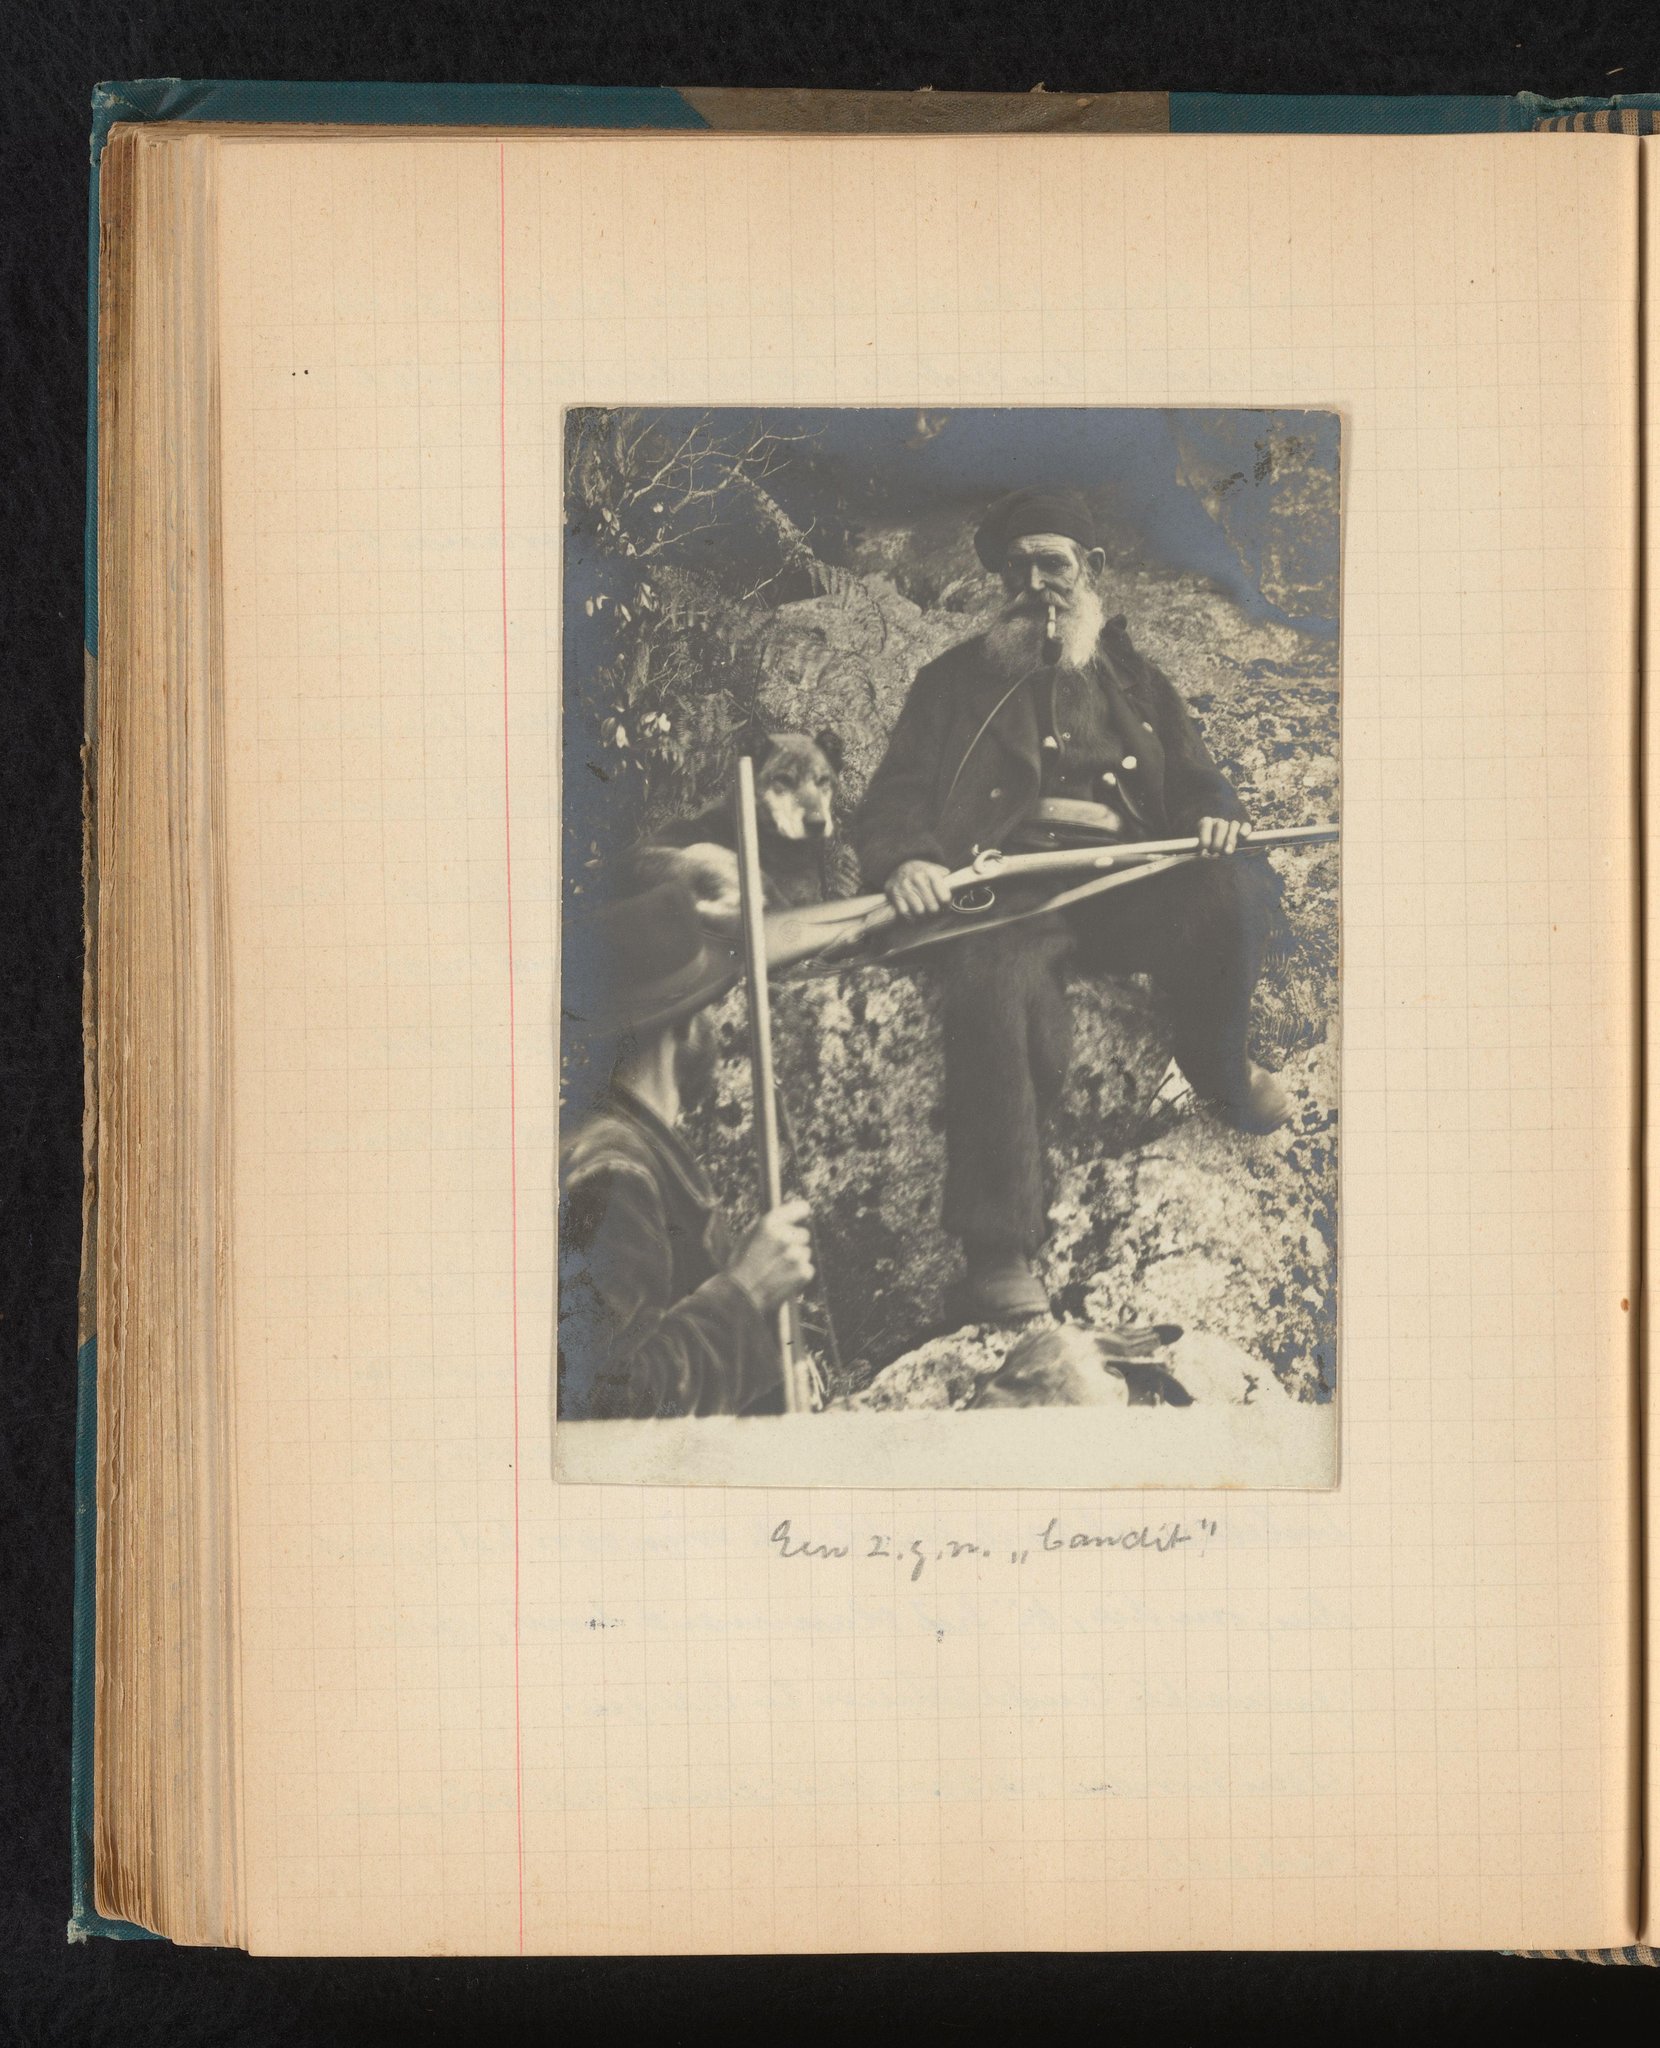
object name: photograph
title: Beruchte bandiet Francois Antoine Bonelli, of Antoine Bellascosia, en een onbekende man met geweren op een rotswand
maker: théodore van lelyveld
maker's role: painter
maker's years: 1867-1954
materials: paper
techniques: gelatin silver print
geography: corsica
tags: historical persons, firearms: rifle, rock-formations, criminals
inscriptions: inscription: ‘Een z.g.n. "bandit"’